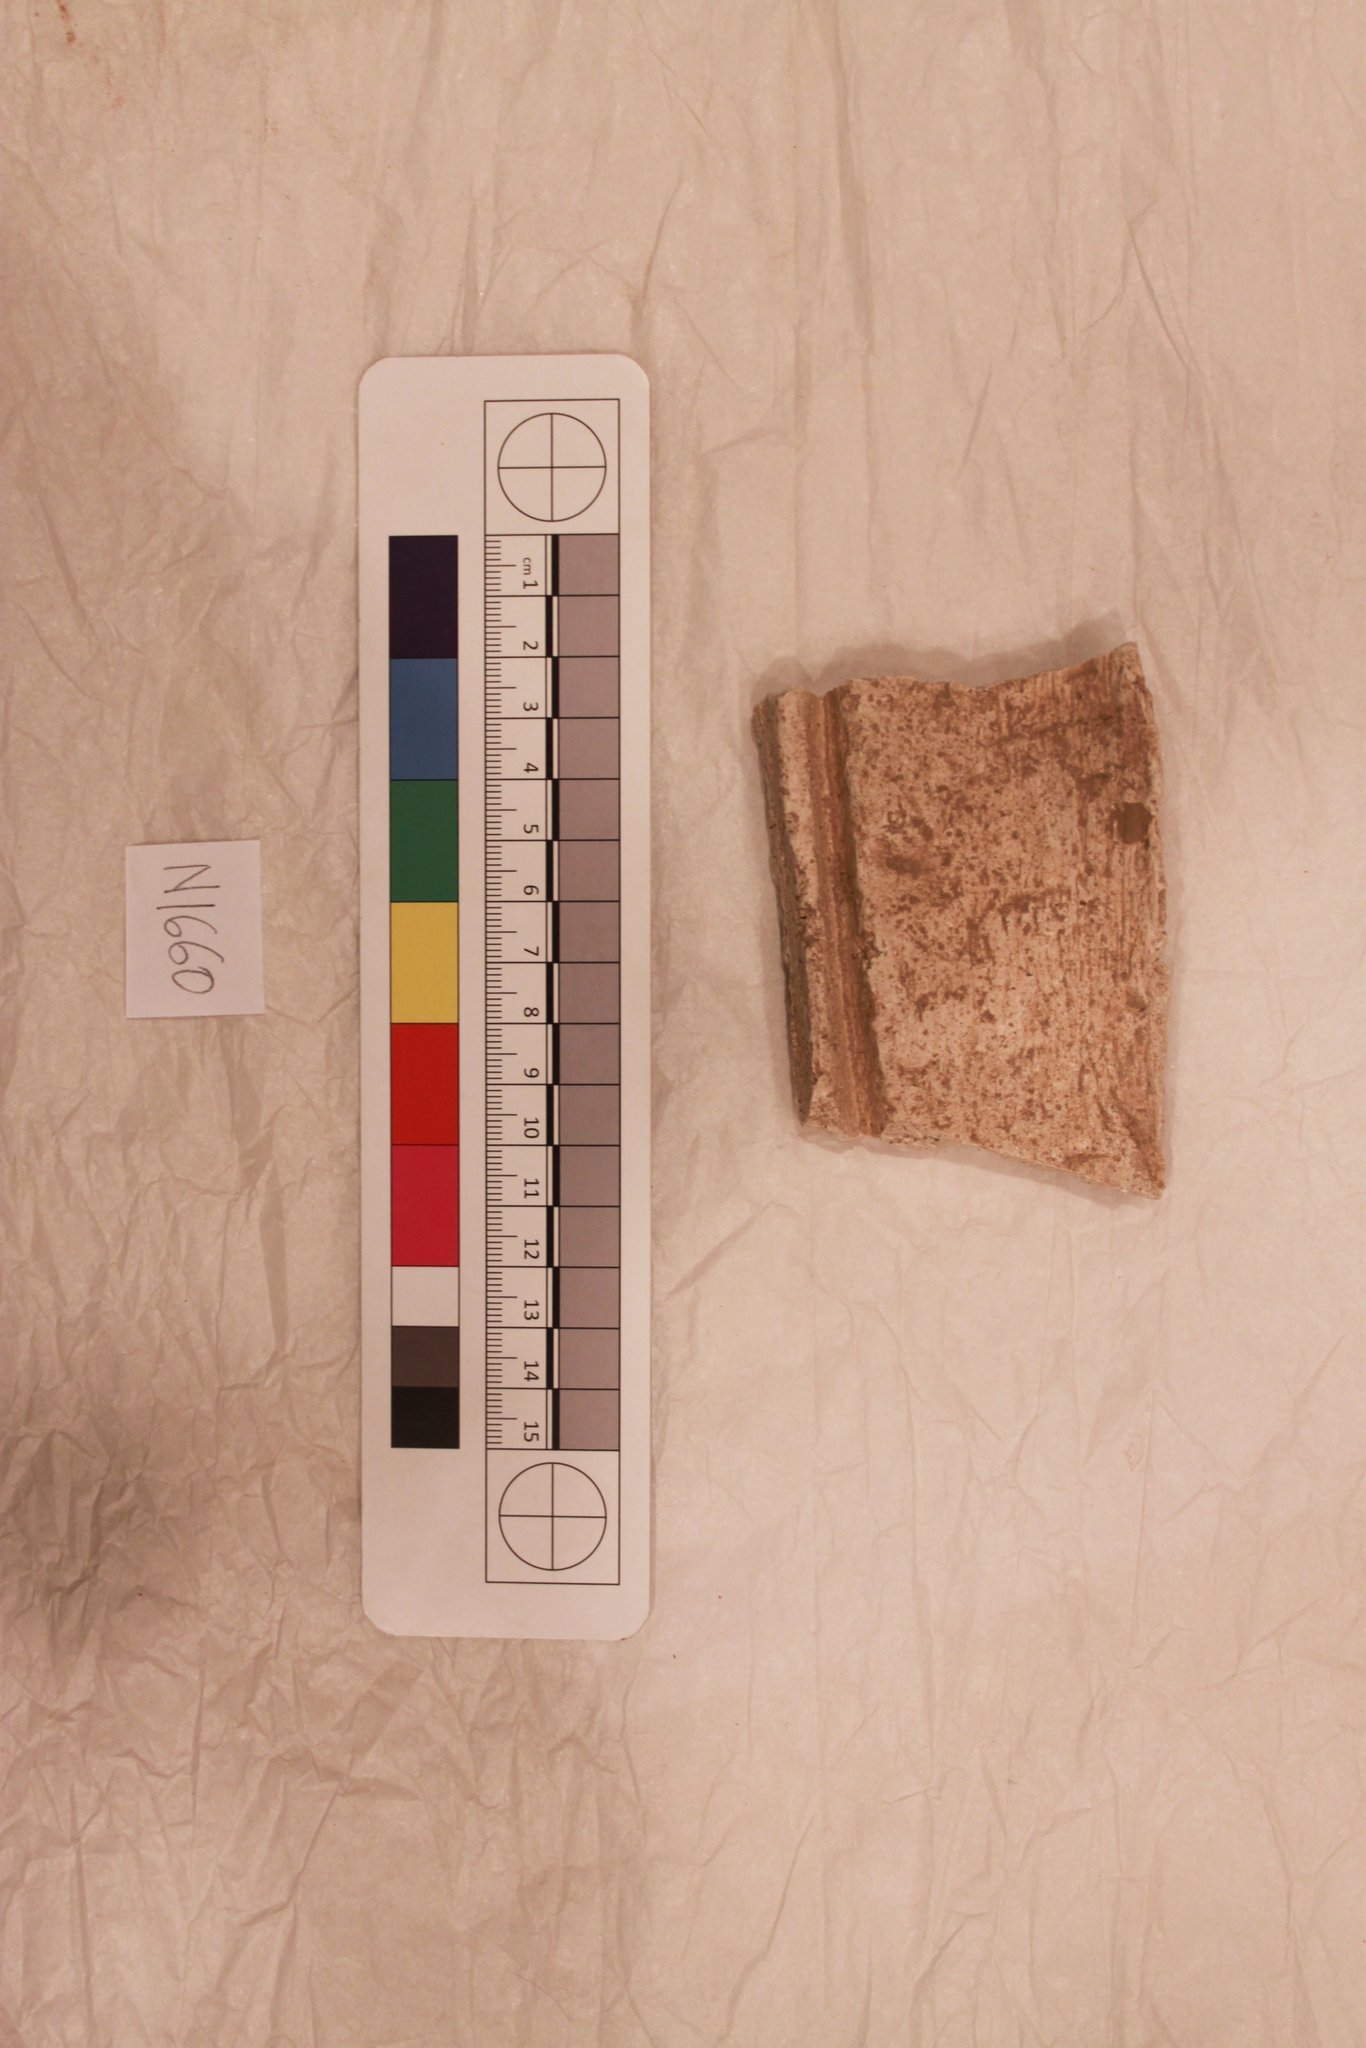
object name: fragment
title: Stucco Fragment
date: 701-1200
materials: plaster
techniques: carving, painting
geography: iran